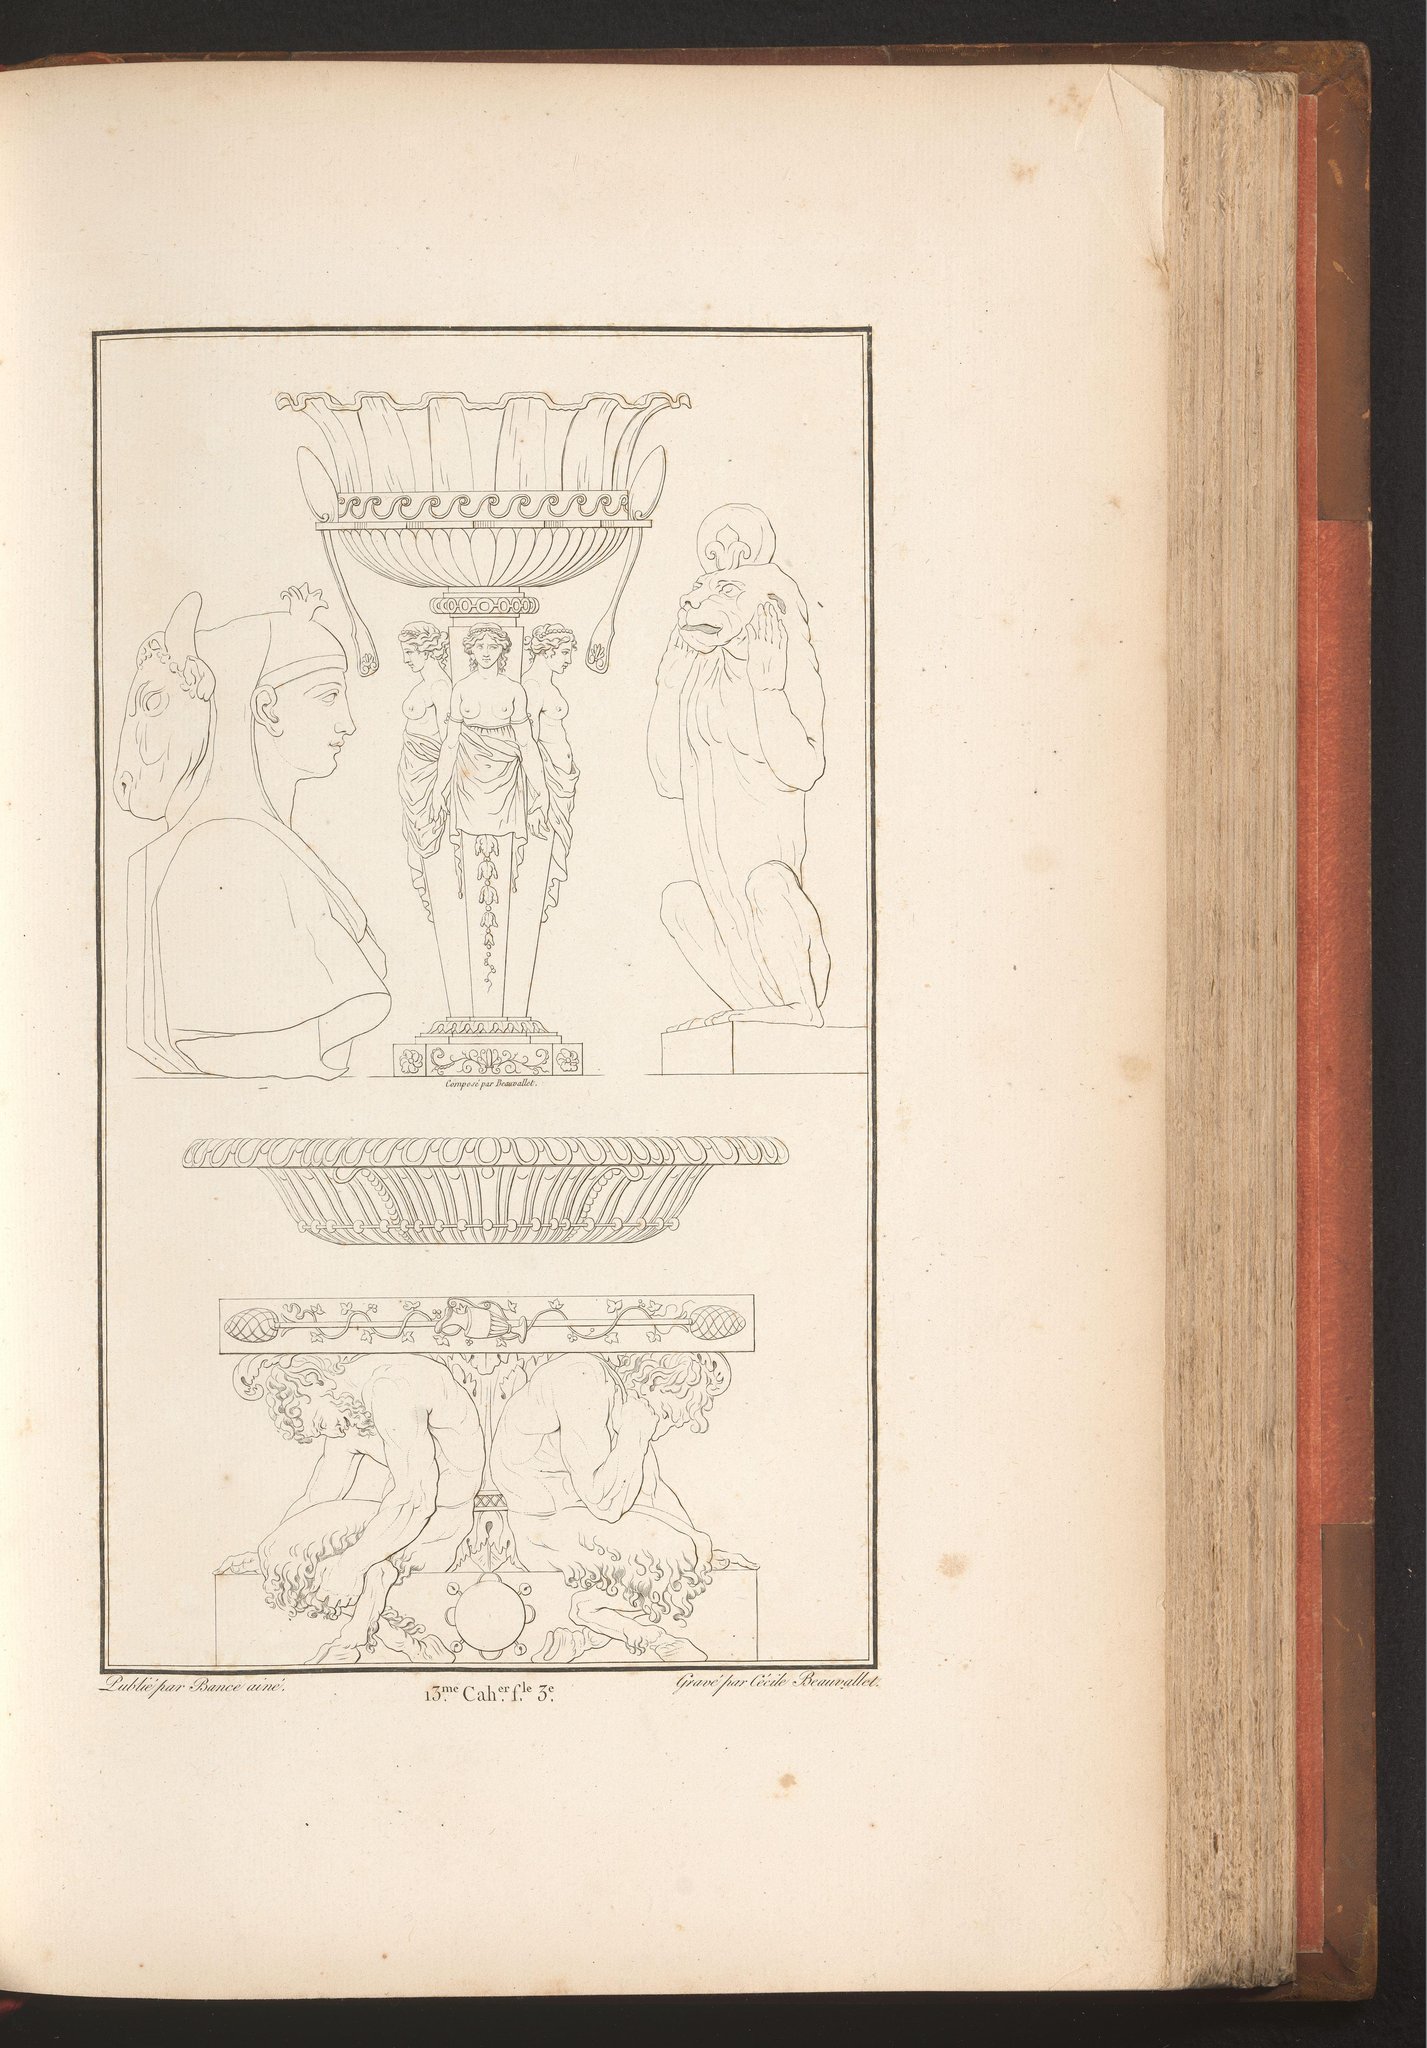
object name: ornament print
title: Diverse ornamenten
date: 1820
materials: paper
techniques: etching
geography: paris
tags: ornaments ~ art, table, satyr(s) (in general)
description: Ornamentprent met onderaan een tafel gedrgaen door twee saters. Onderdeel (13e. Cah. f.le 3) van het prentalbum met twee series van in totaal 138 ornamentprenten door Beauvallet en Normand, 'Fragmens d'Ornemens dans le Style Antique'.